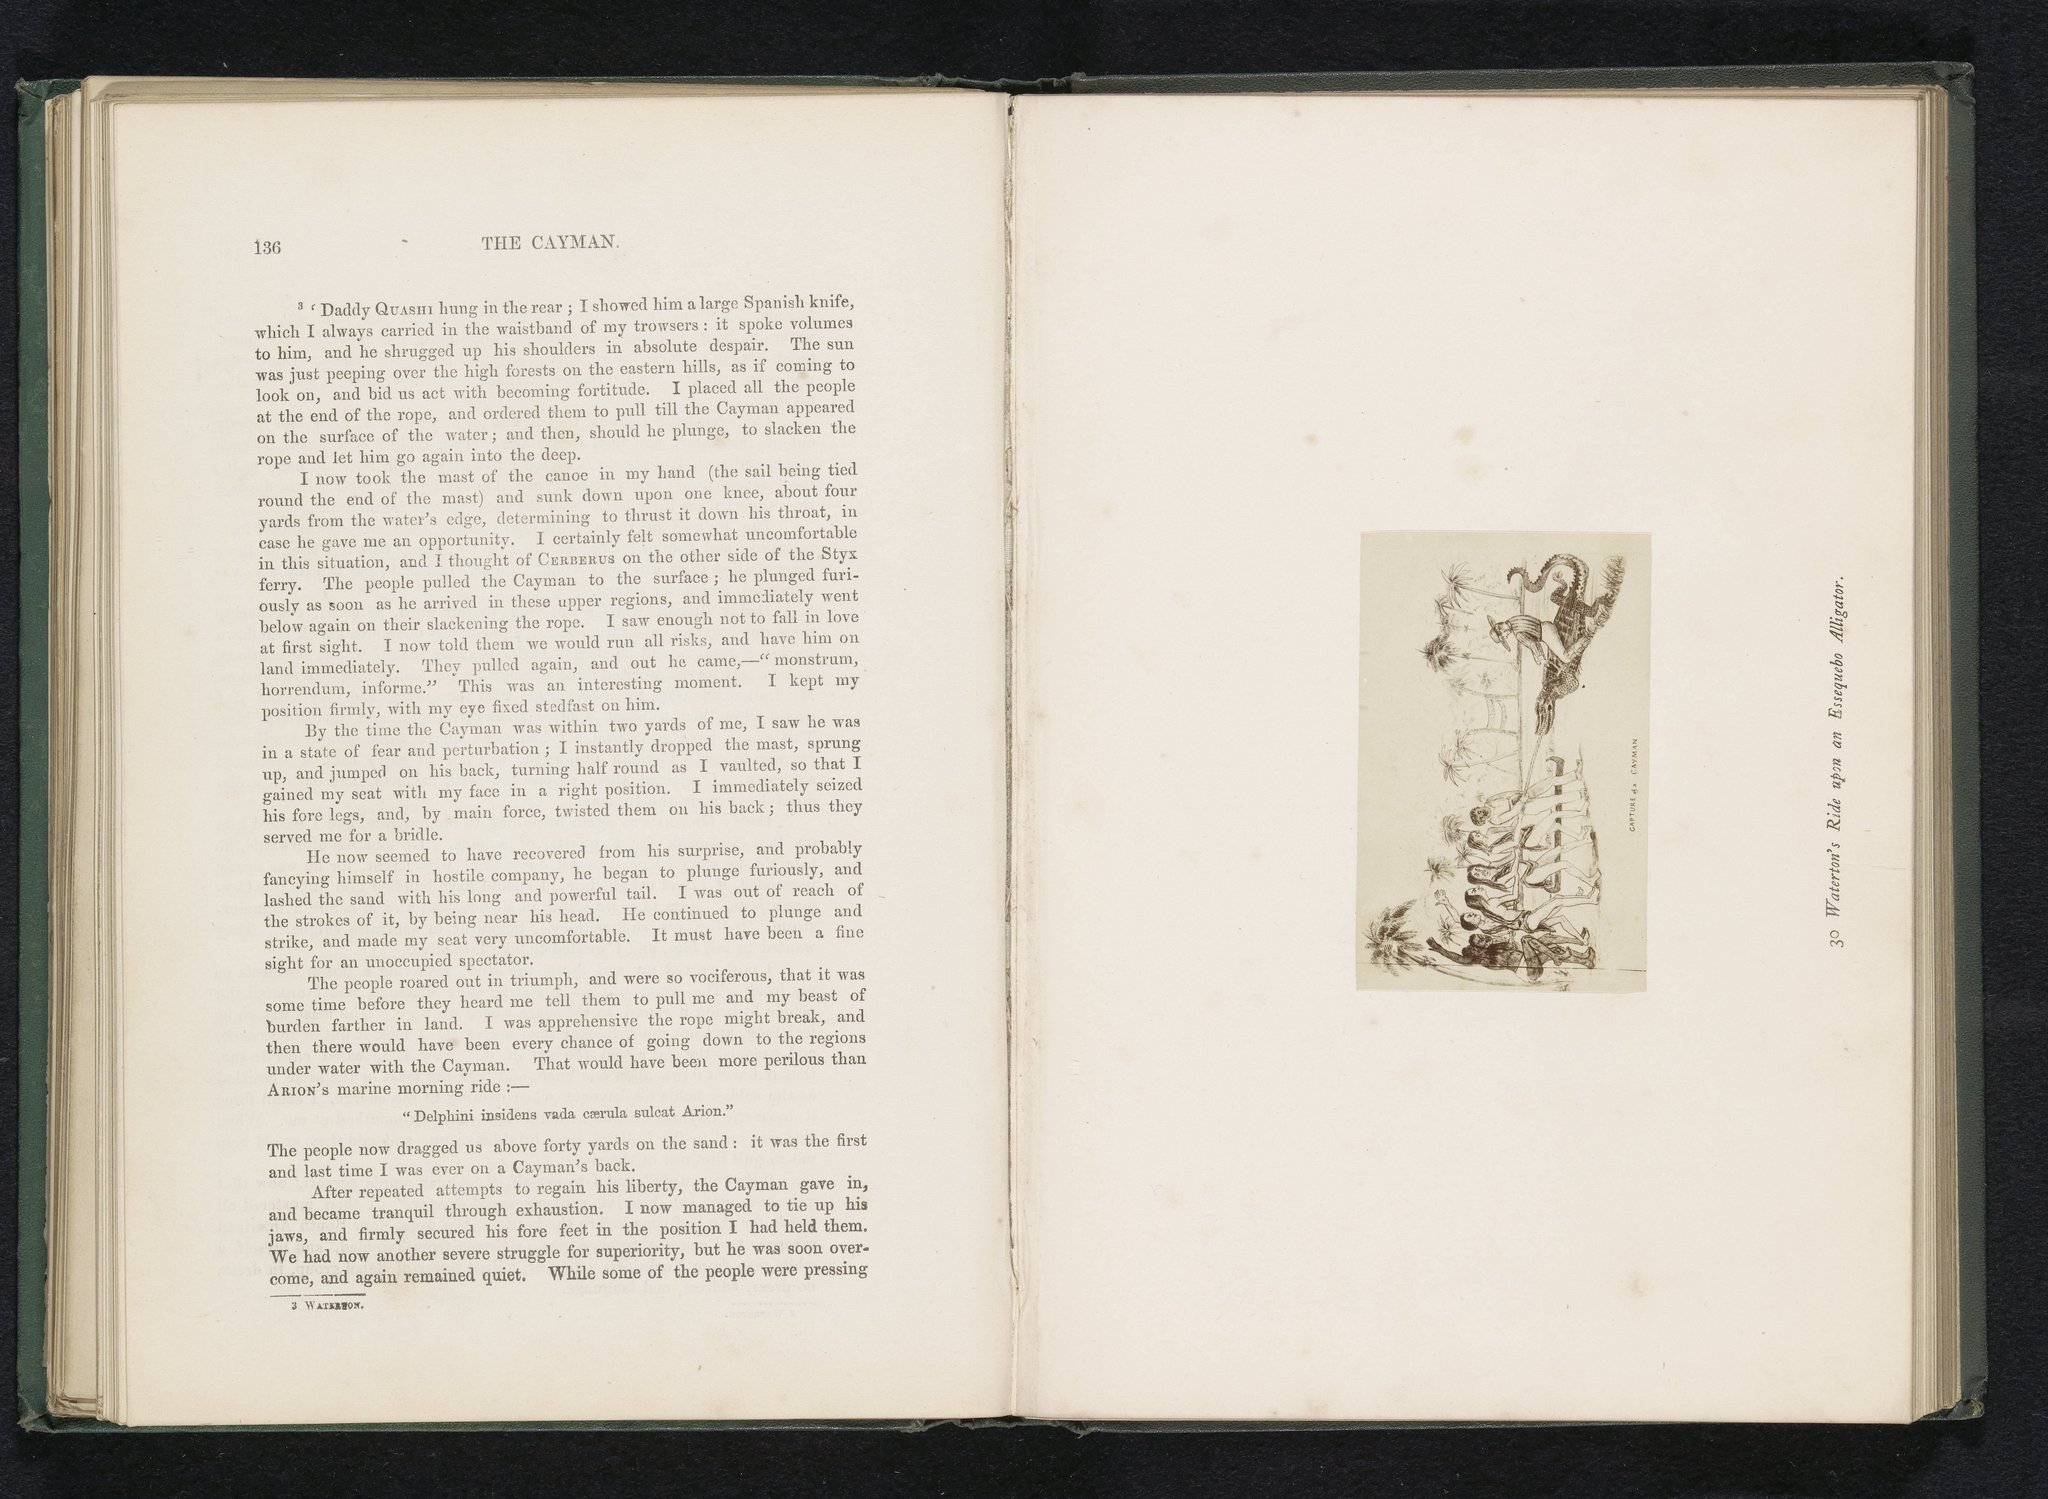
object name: page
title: Capture of a Cayman Waterton's Ride upon an Essequebo Alligator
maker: Anonymous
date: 1856-1866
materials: photographic support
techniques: albumen print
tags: crocodiles: alligator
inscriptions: number: ‘30’